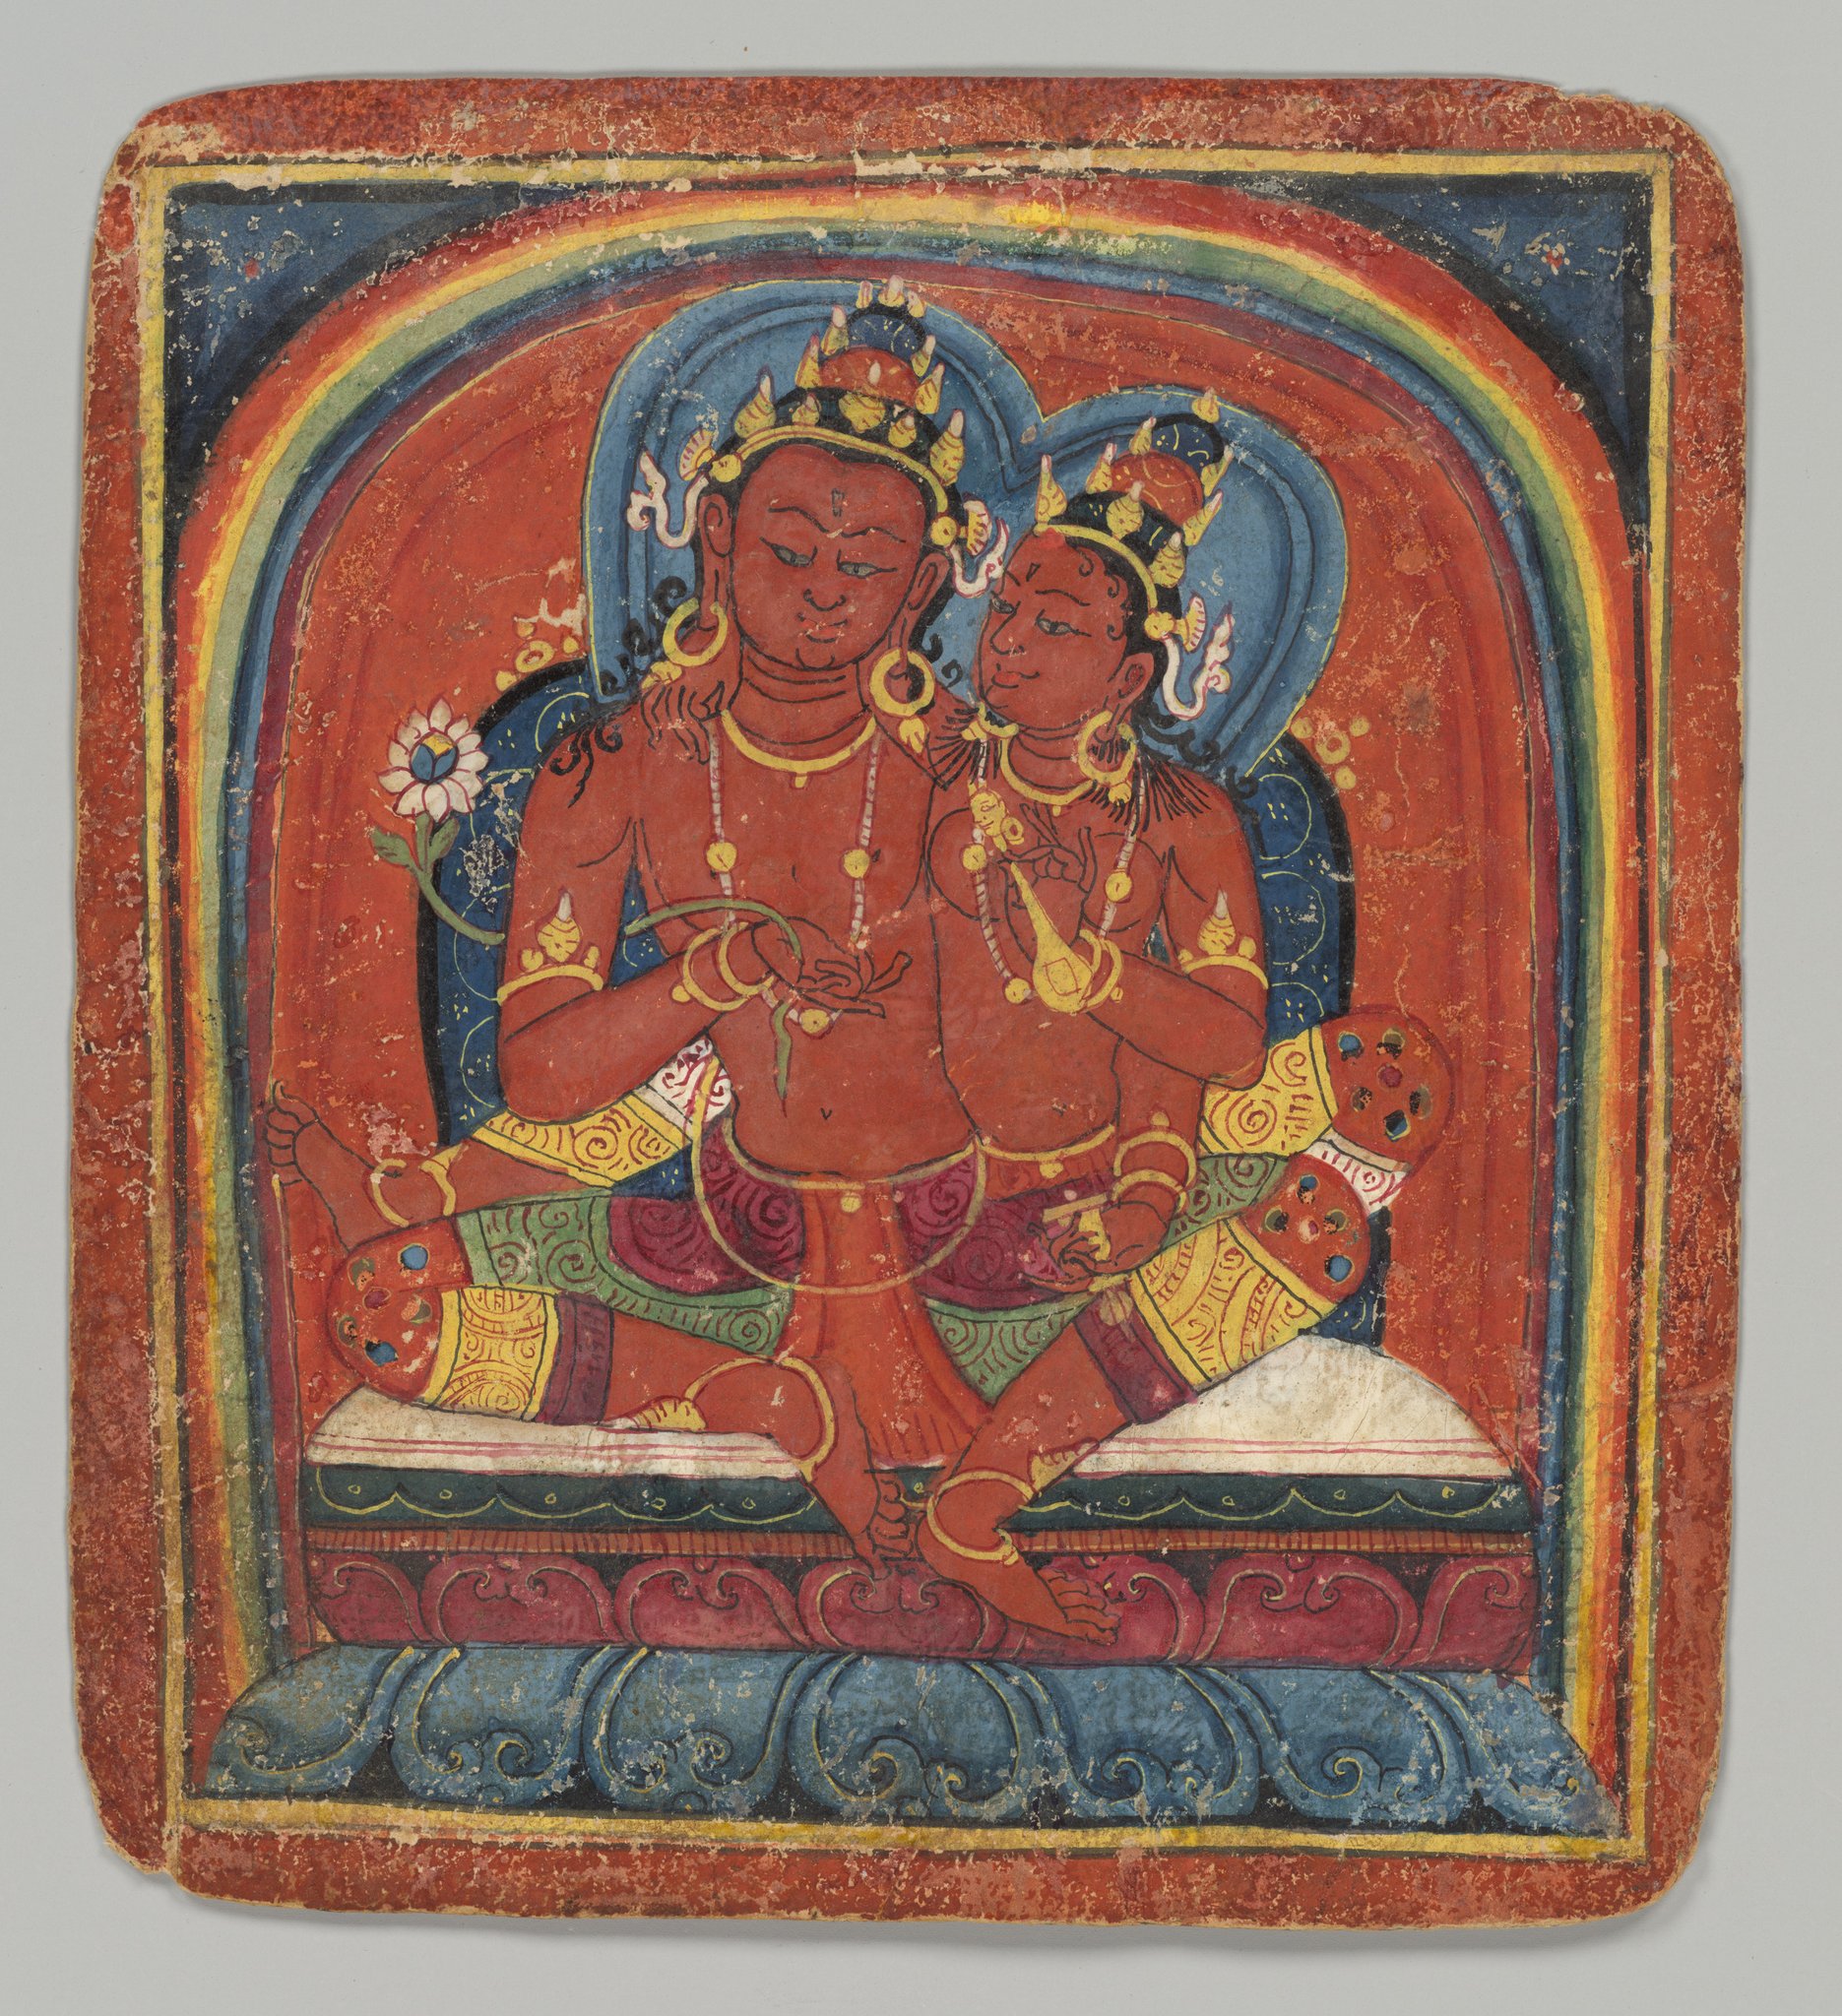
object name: initiation card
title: Initiation Card (Tsakalis): Chenresi (Avalokiteshvara)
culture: tibetan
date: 1401-1433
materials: paper, watercolor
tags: buddhism